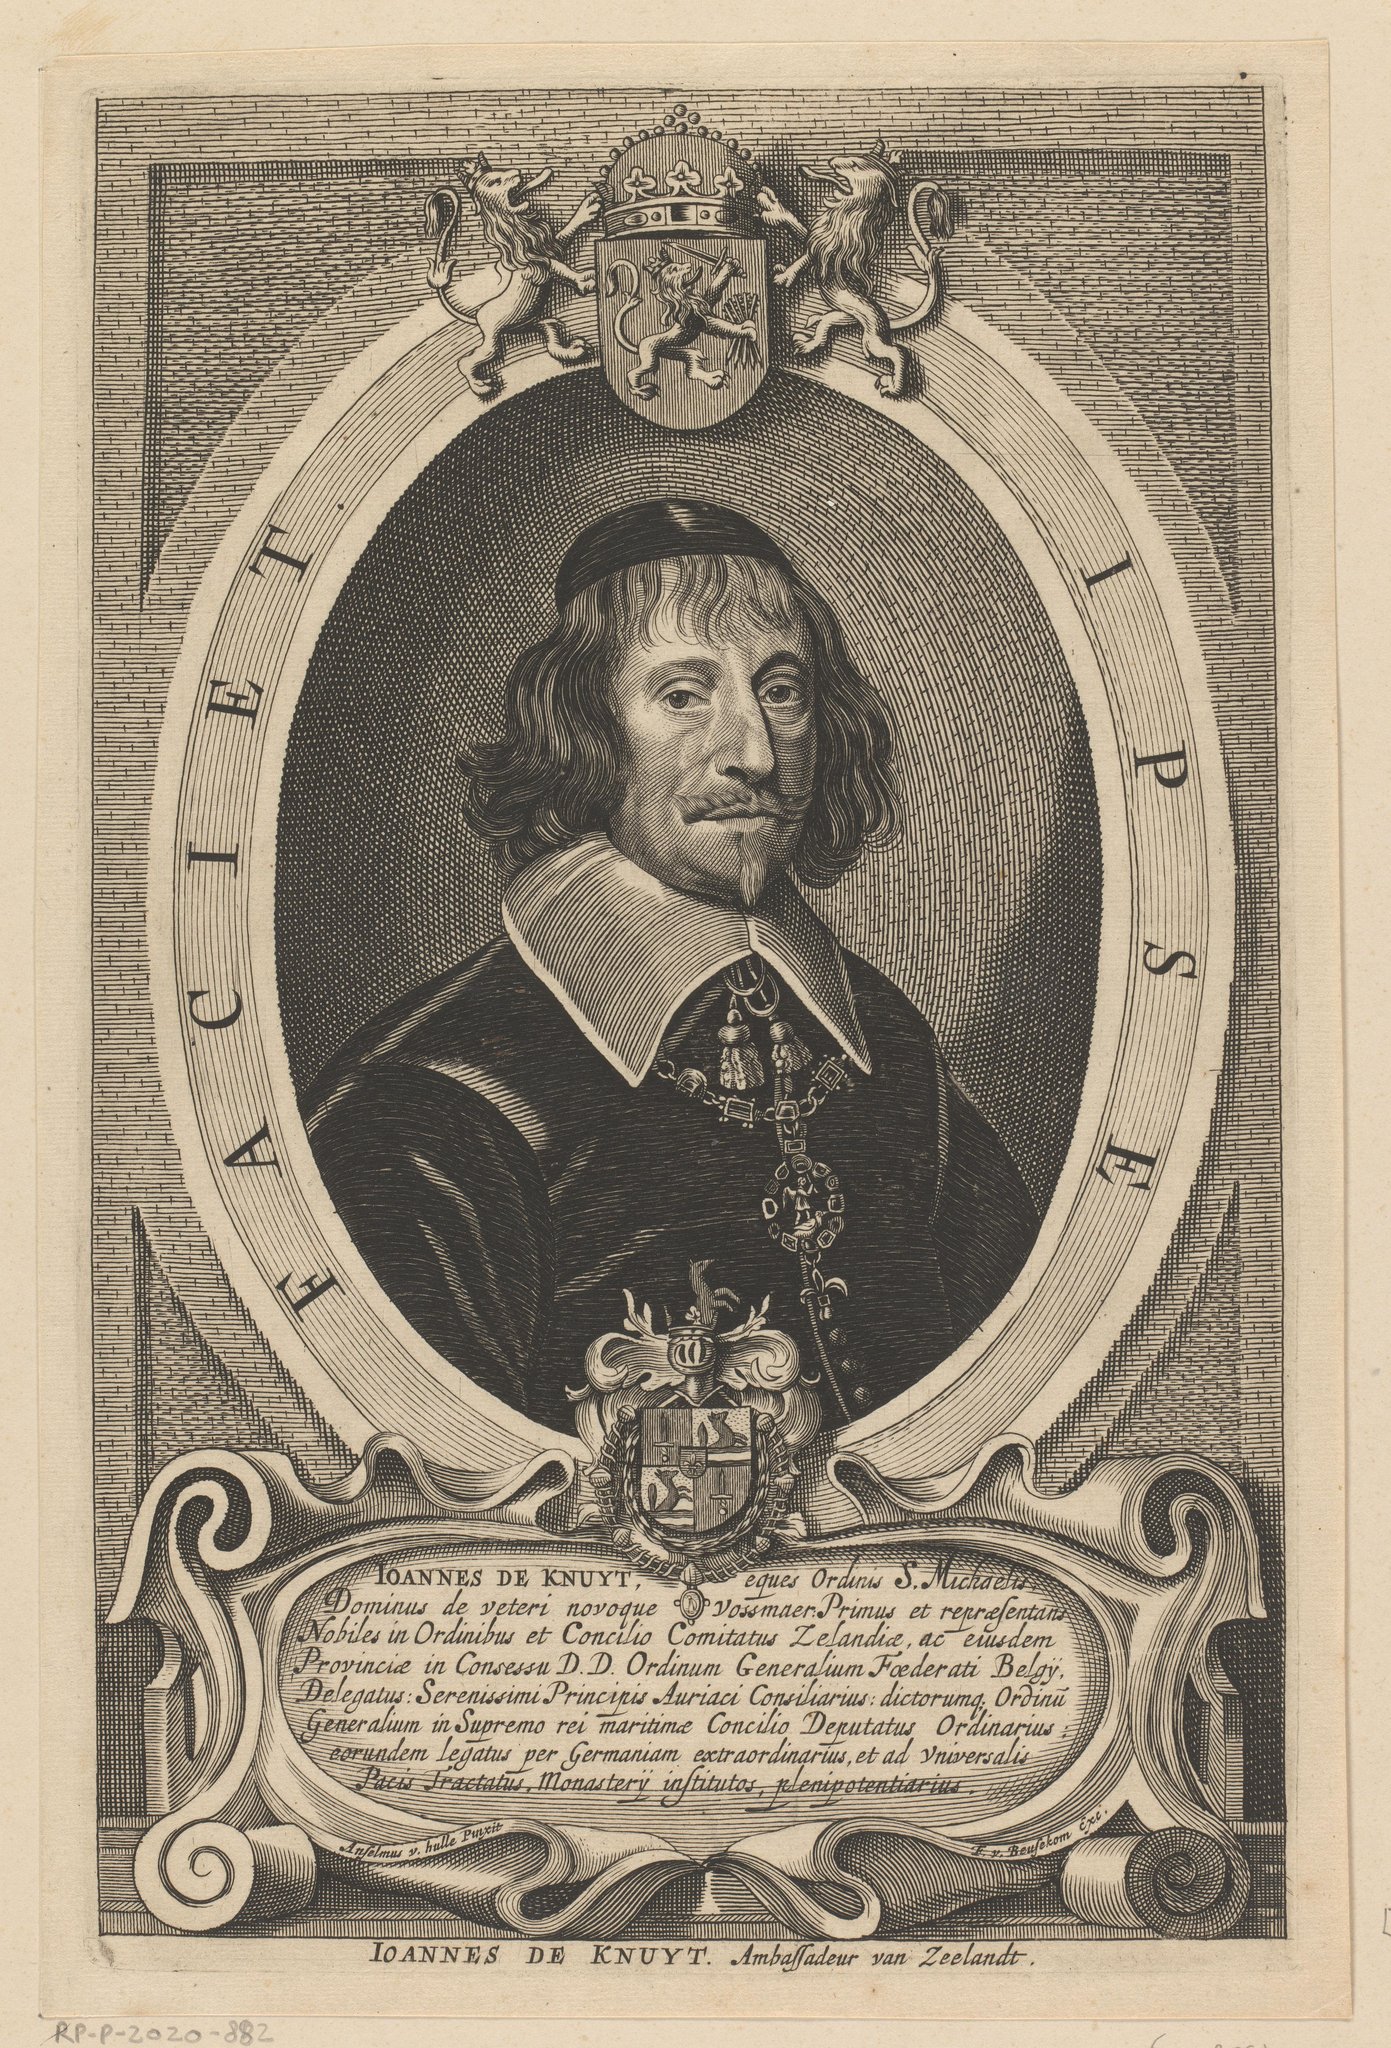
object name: print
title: Portret van Johan de Knuyt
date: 1648-1665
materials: paper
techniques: engraving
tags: historical persons, diplomacy, diplomat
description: Spiegelbeeldige kopie naar een prent van Paulus Pontius. Zie documentatie. De prent maakt waarschijnlijk onderdeel uit van een serie portretten met vredesonderhandelaars die betrokken waren bij de Vrede van Münster.